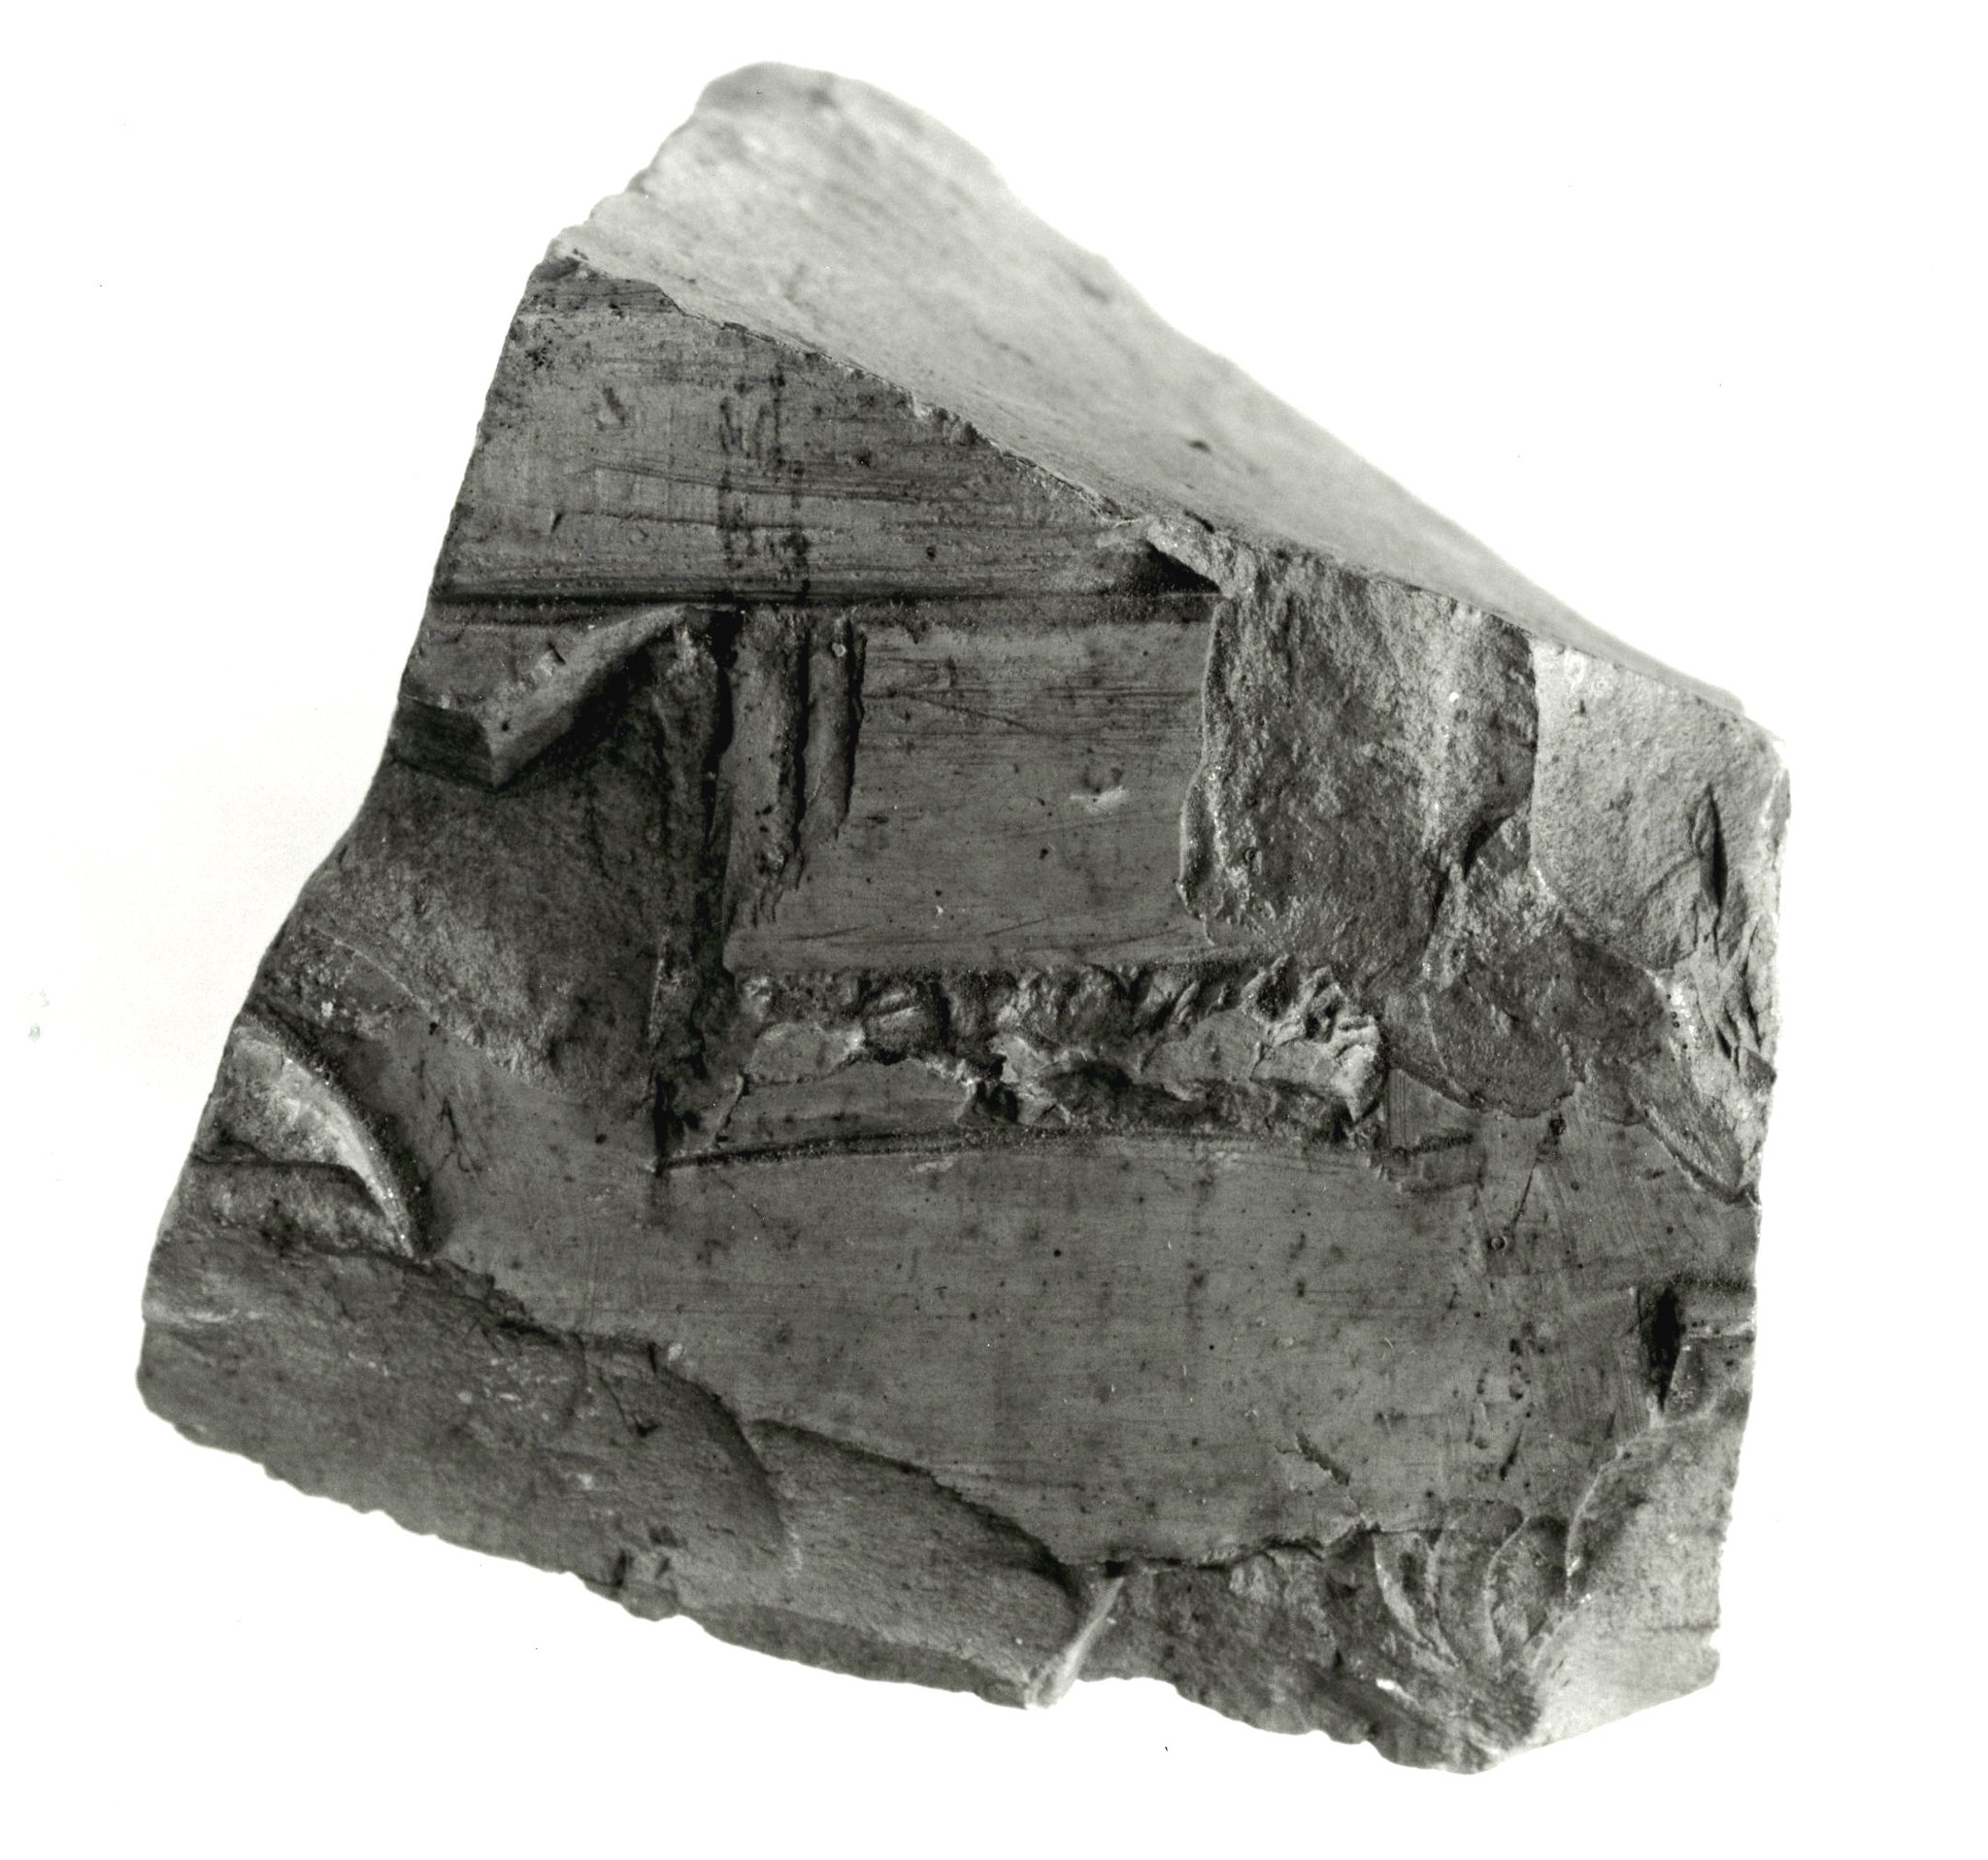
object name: relief, tomb of nespekashuty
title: Raised relief fragment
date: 664-610 BCE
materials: limestone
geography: egypt